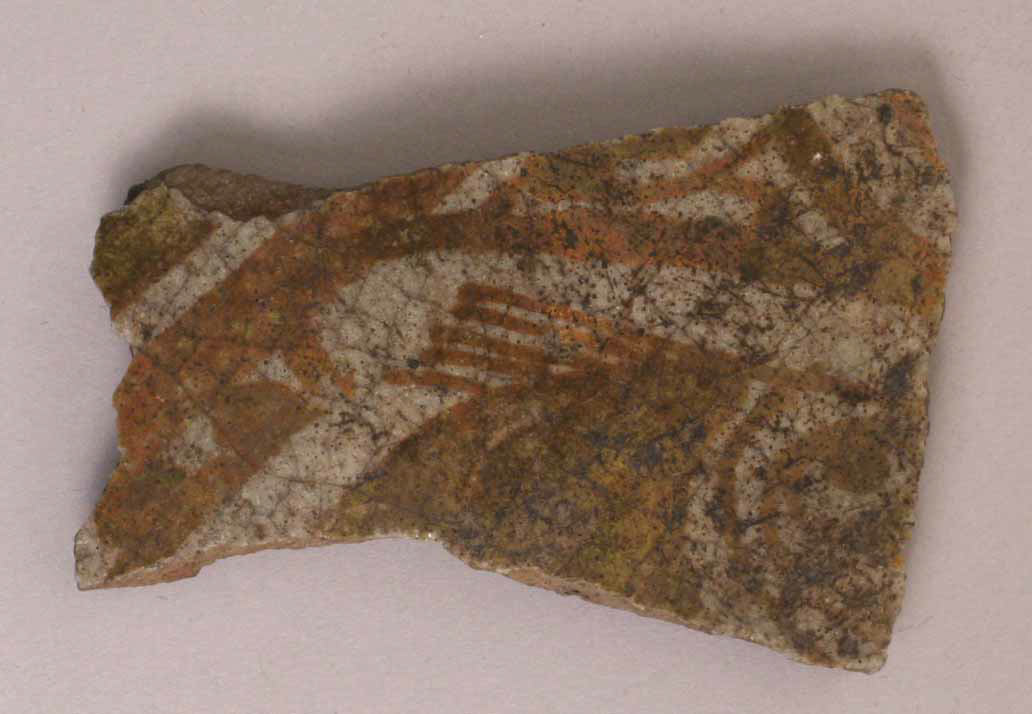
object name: ceramic fragment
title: Fragment of a Dish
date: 1001-1200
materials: earthenware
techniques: luster painting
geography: egypt